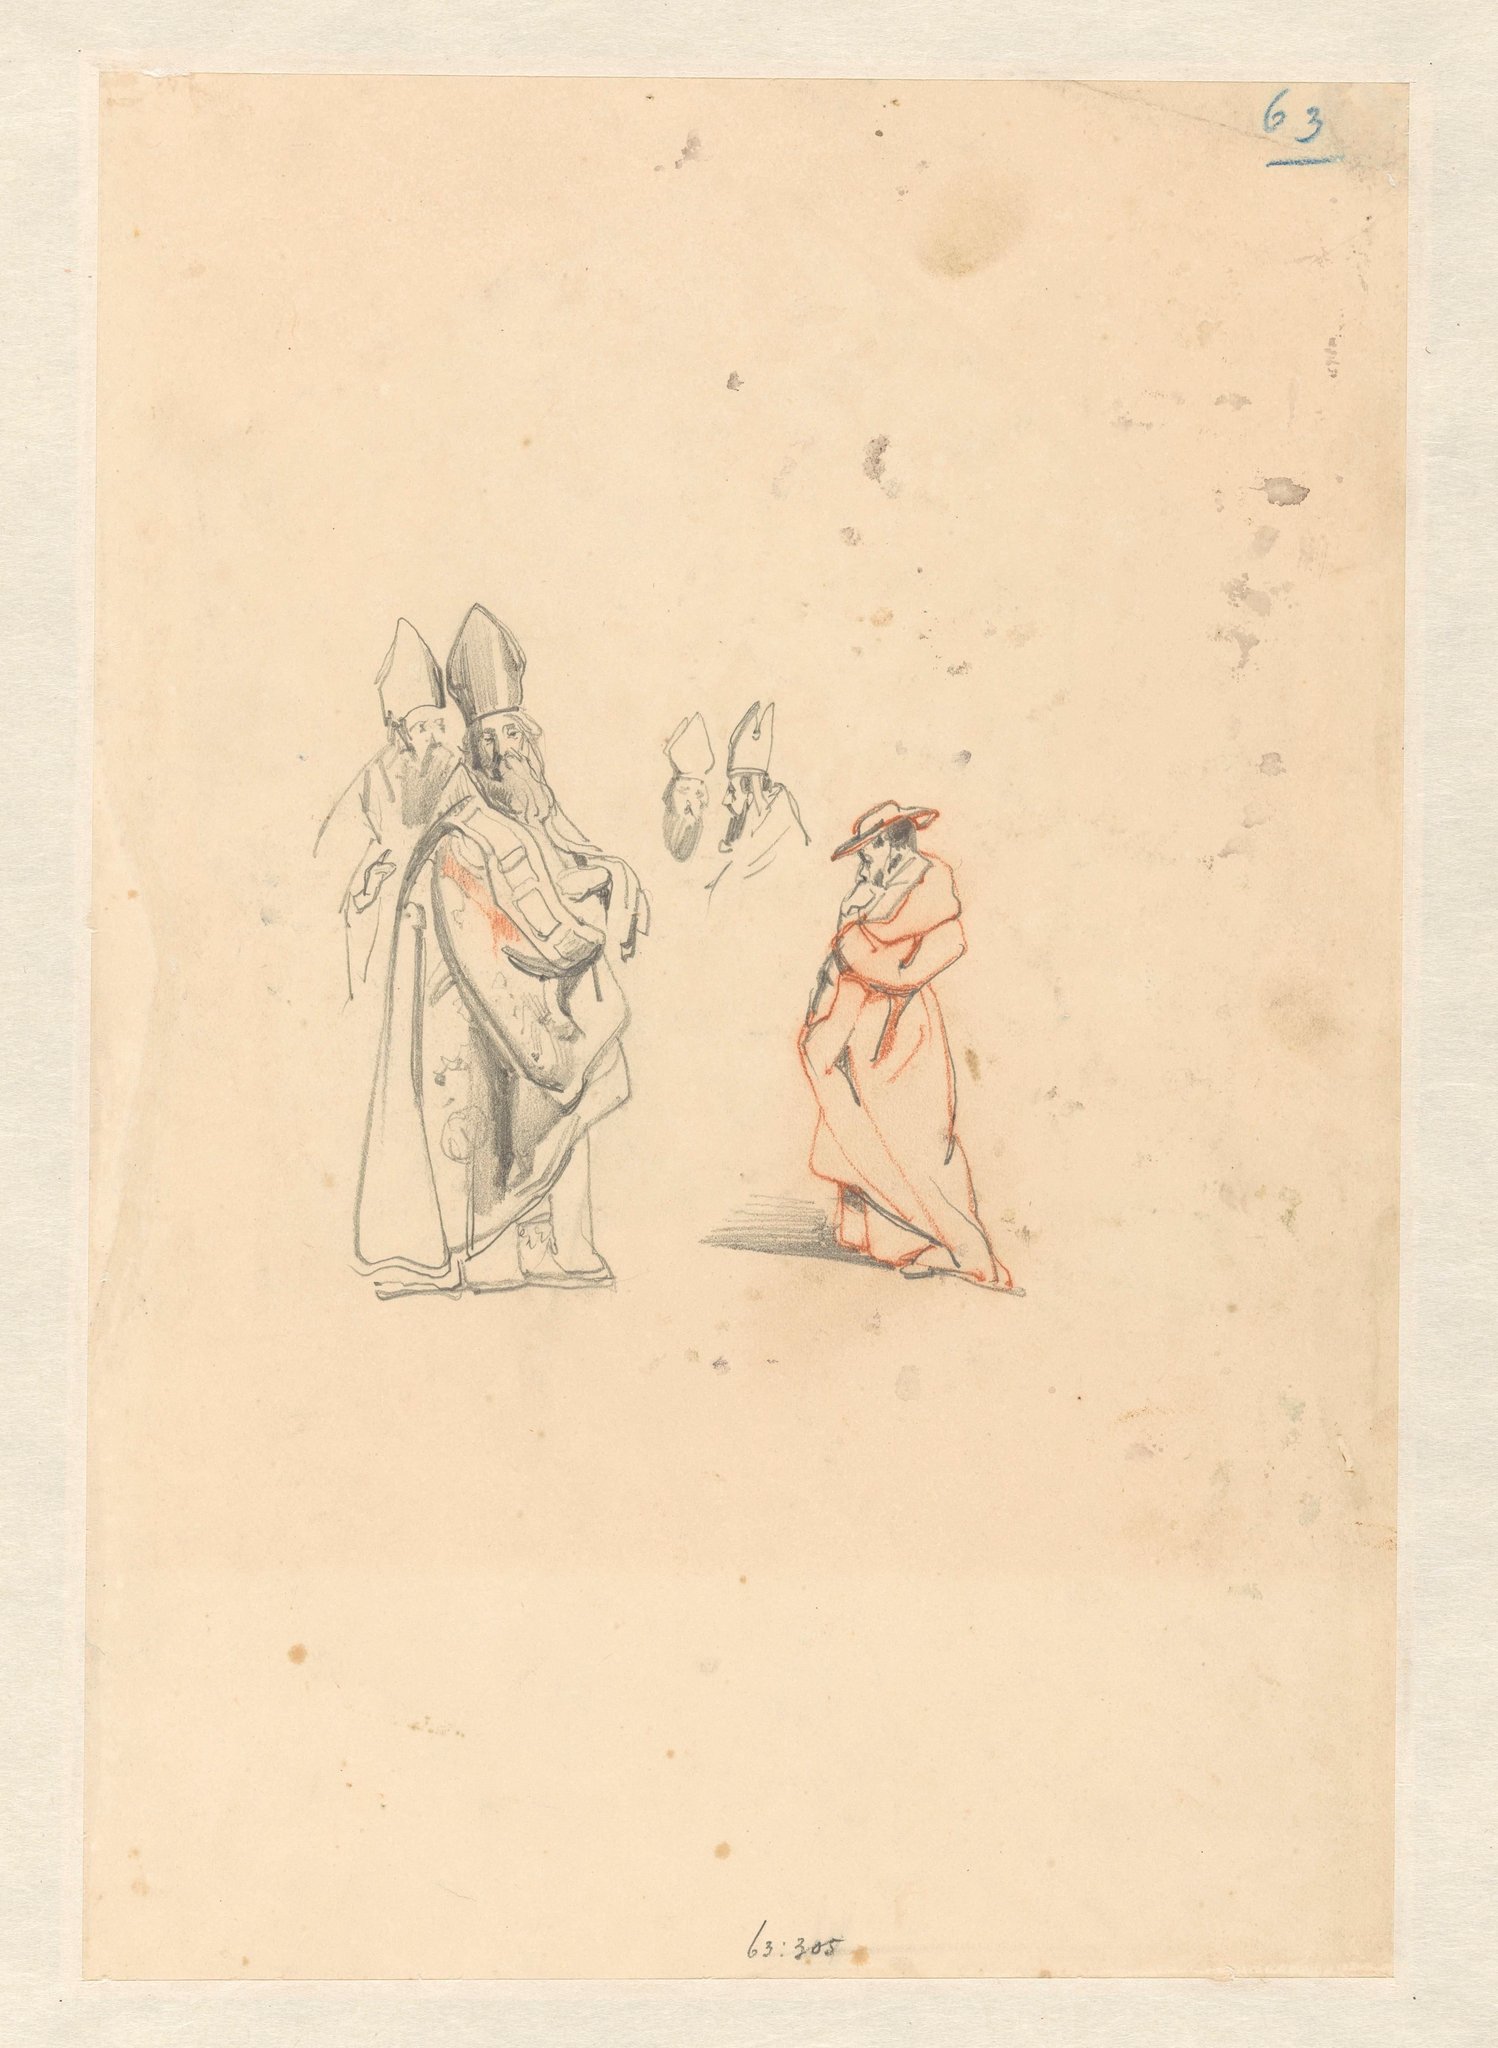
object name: drawing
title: Studies van bisschoppen en een kardinaal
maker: johannes bosboom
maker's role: draughtsman, painter, print maker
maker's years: 1817-1891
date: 1827-1891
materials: chalk, paper, pencil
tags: archbishop, bishop, etc. (roman catholic), cardinal